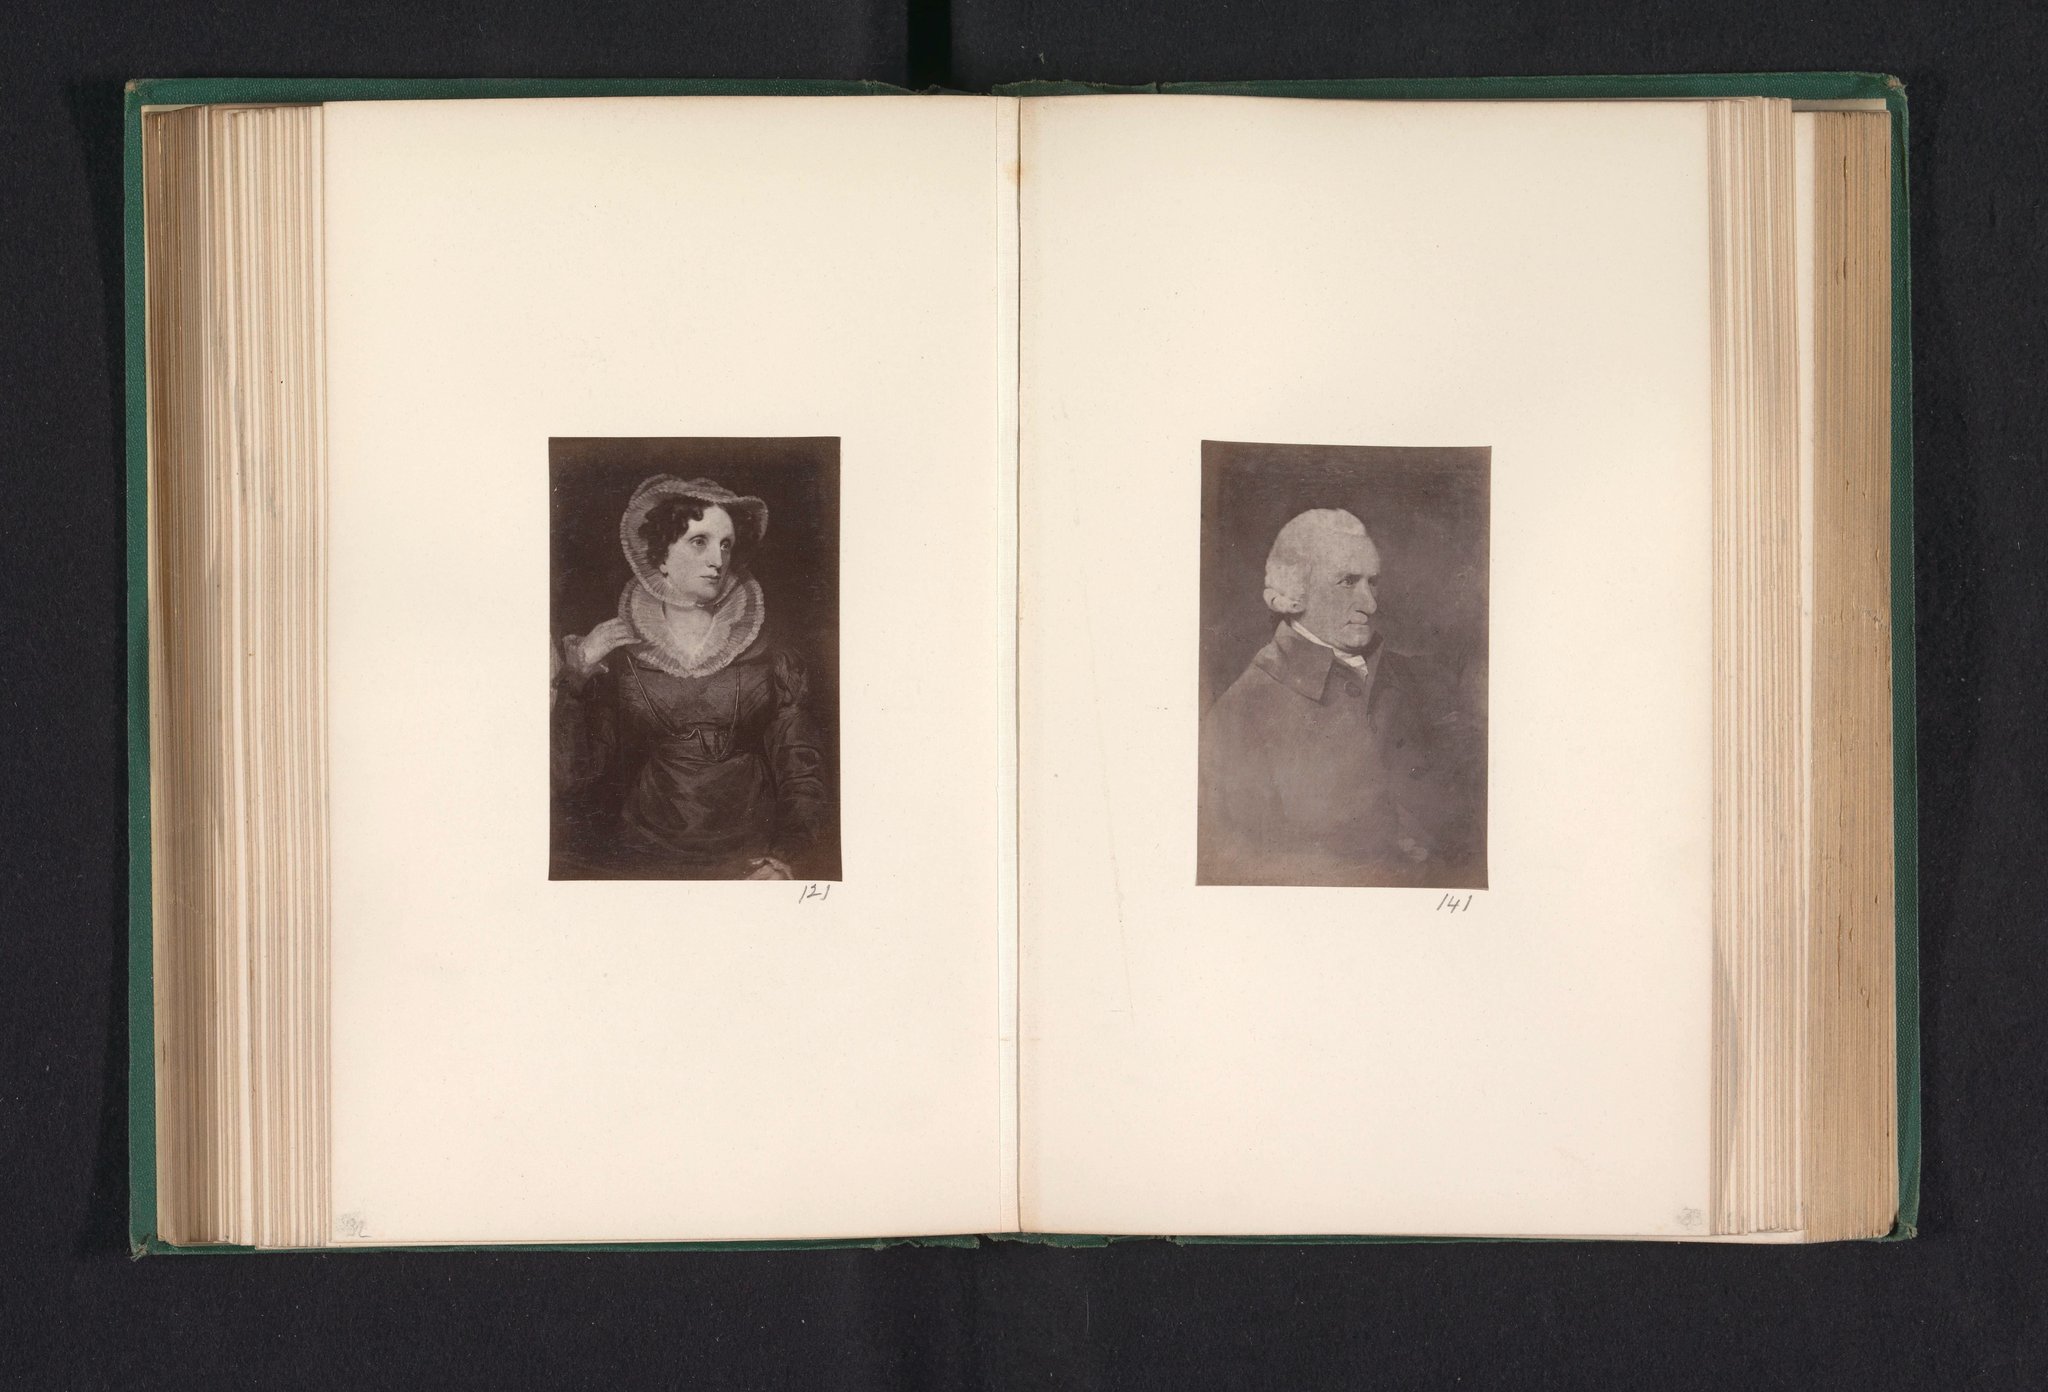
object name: page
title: Fotoreproductie van een schilderij, voorstellende een portret van Mrs. Stewart Smith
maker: thomas annan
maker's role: fotograaf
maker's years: 1829-1887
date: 1863-1868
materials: photographic support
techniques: albumen print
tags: historical persons (portraits and scenes from the life) (+ (full) bust portrait)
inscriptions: number: ‘121’